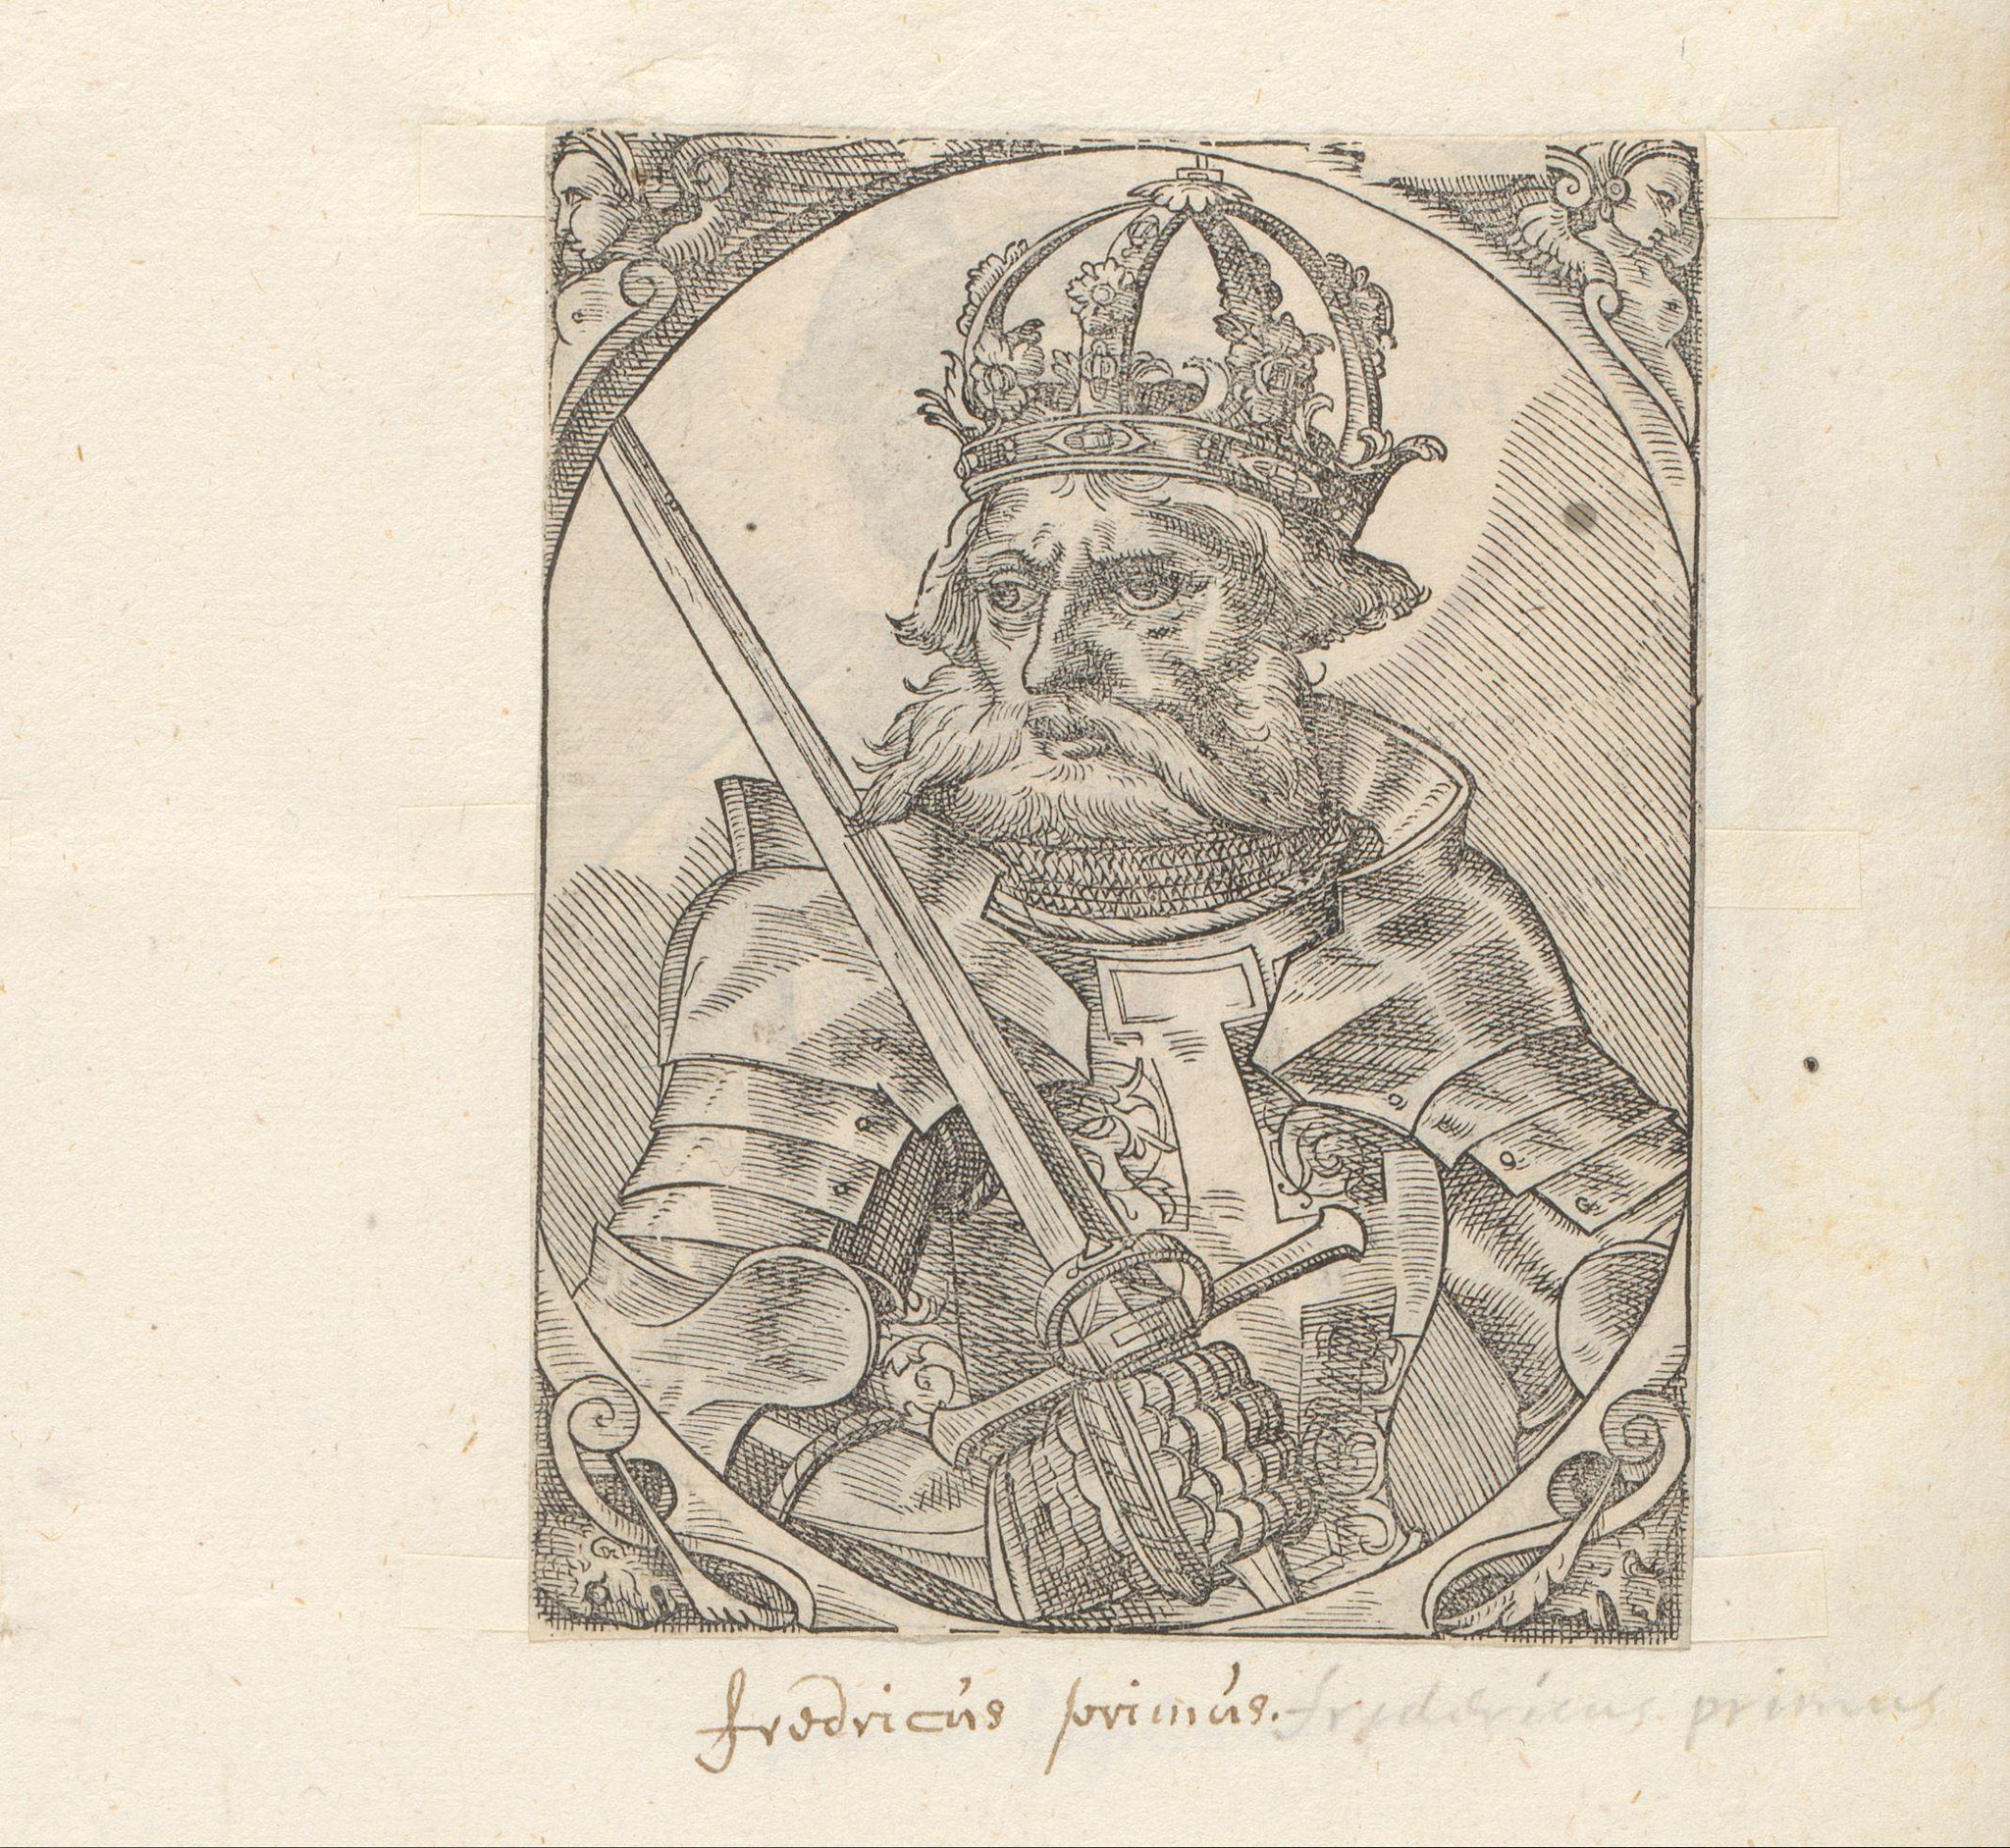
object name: print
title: Portret van keizer Frederik I Barbarossa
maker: Anonymous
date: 1549-1575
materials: paper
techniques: woodcut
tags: historical persons, ruler, sovereign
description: Prent gebruikt in: Giovio, Paolo. Elogia Virorum bellica virtute illustrium (...). Bazel: Peter Perna, 1575.